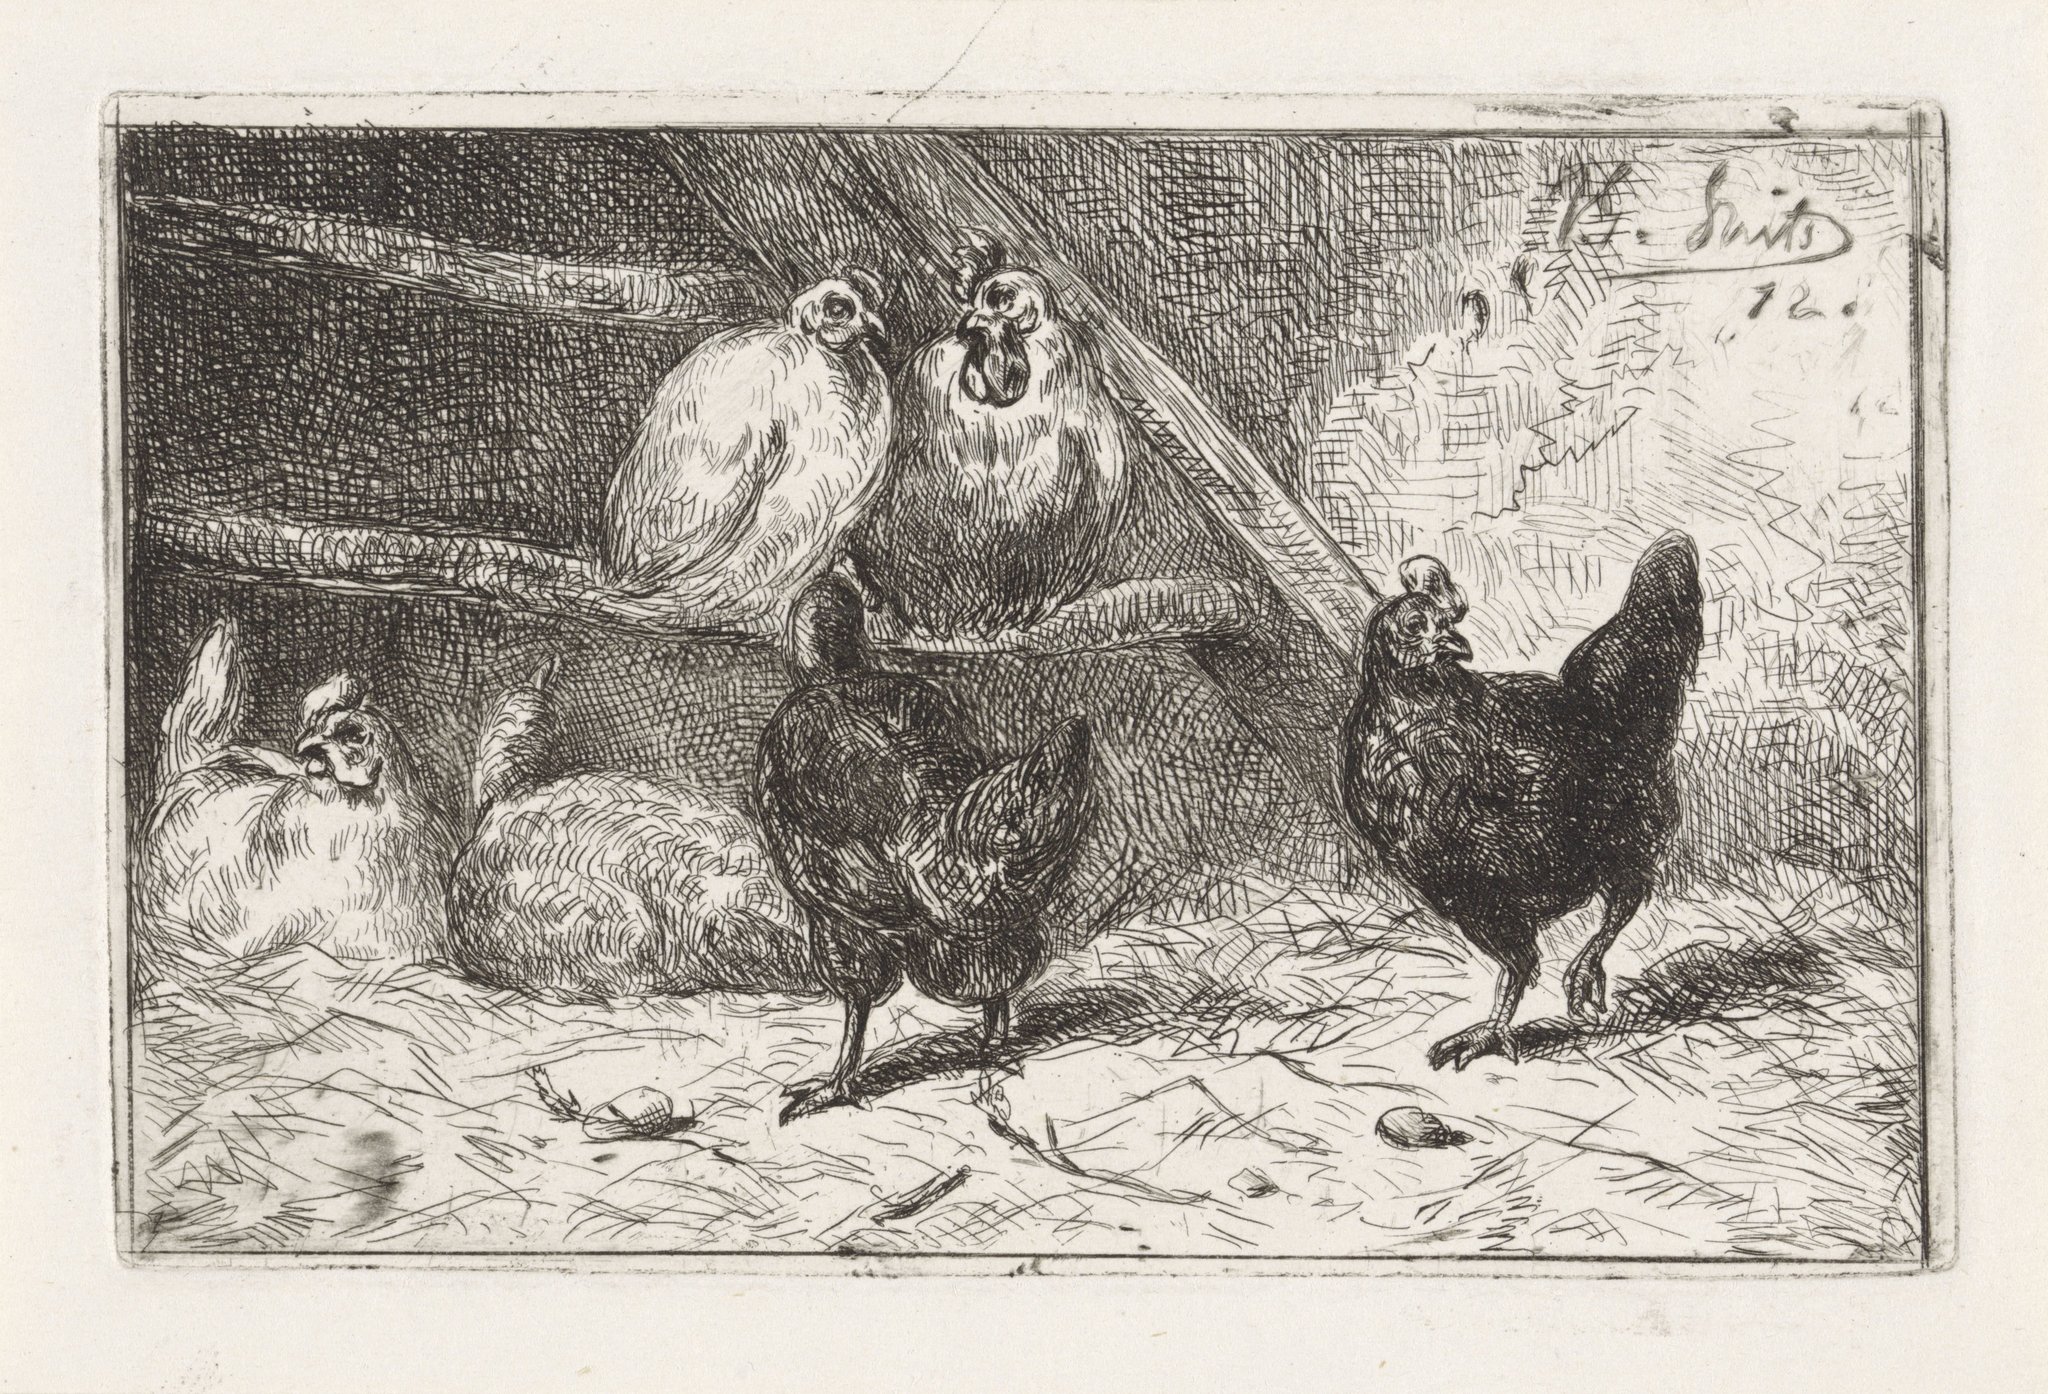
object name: print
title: Haan en vijf kippen in een hok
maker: jan gerard smits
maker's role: draughtsman, print maker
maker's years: 1823-1910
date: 1872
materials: paper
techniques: etching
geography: the hague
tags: fowl (cock, hen, chicken, etc.)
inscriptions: collector's mark: Lugt 2228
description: Haan en vijf kippen in een hok. Twee ervan zitten op stok. Twee zwarte kippen scharrelen rond, de andere twee liggen op de grond.